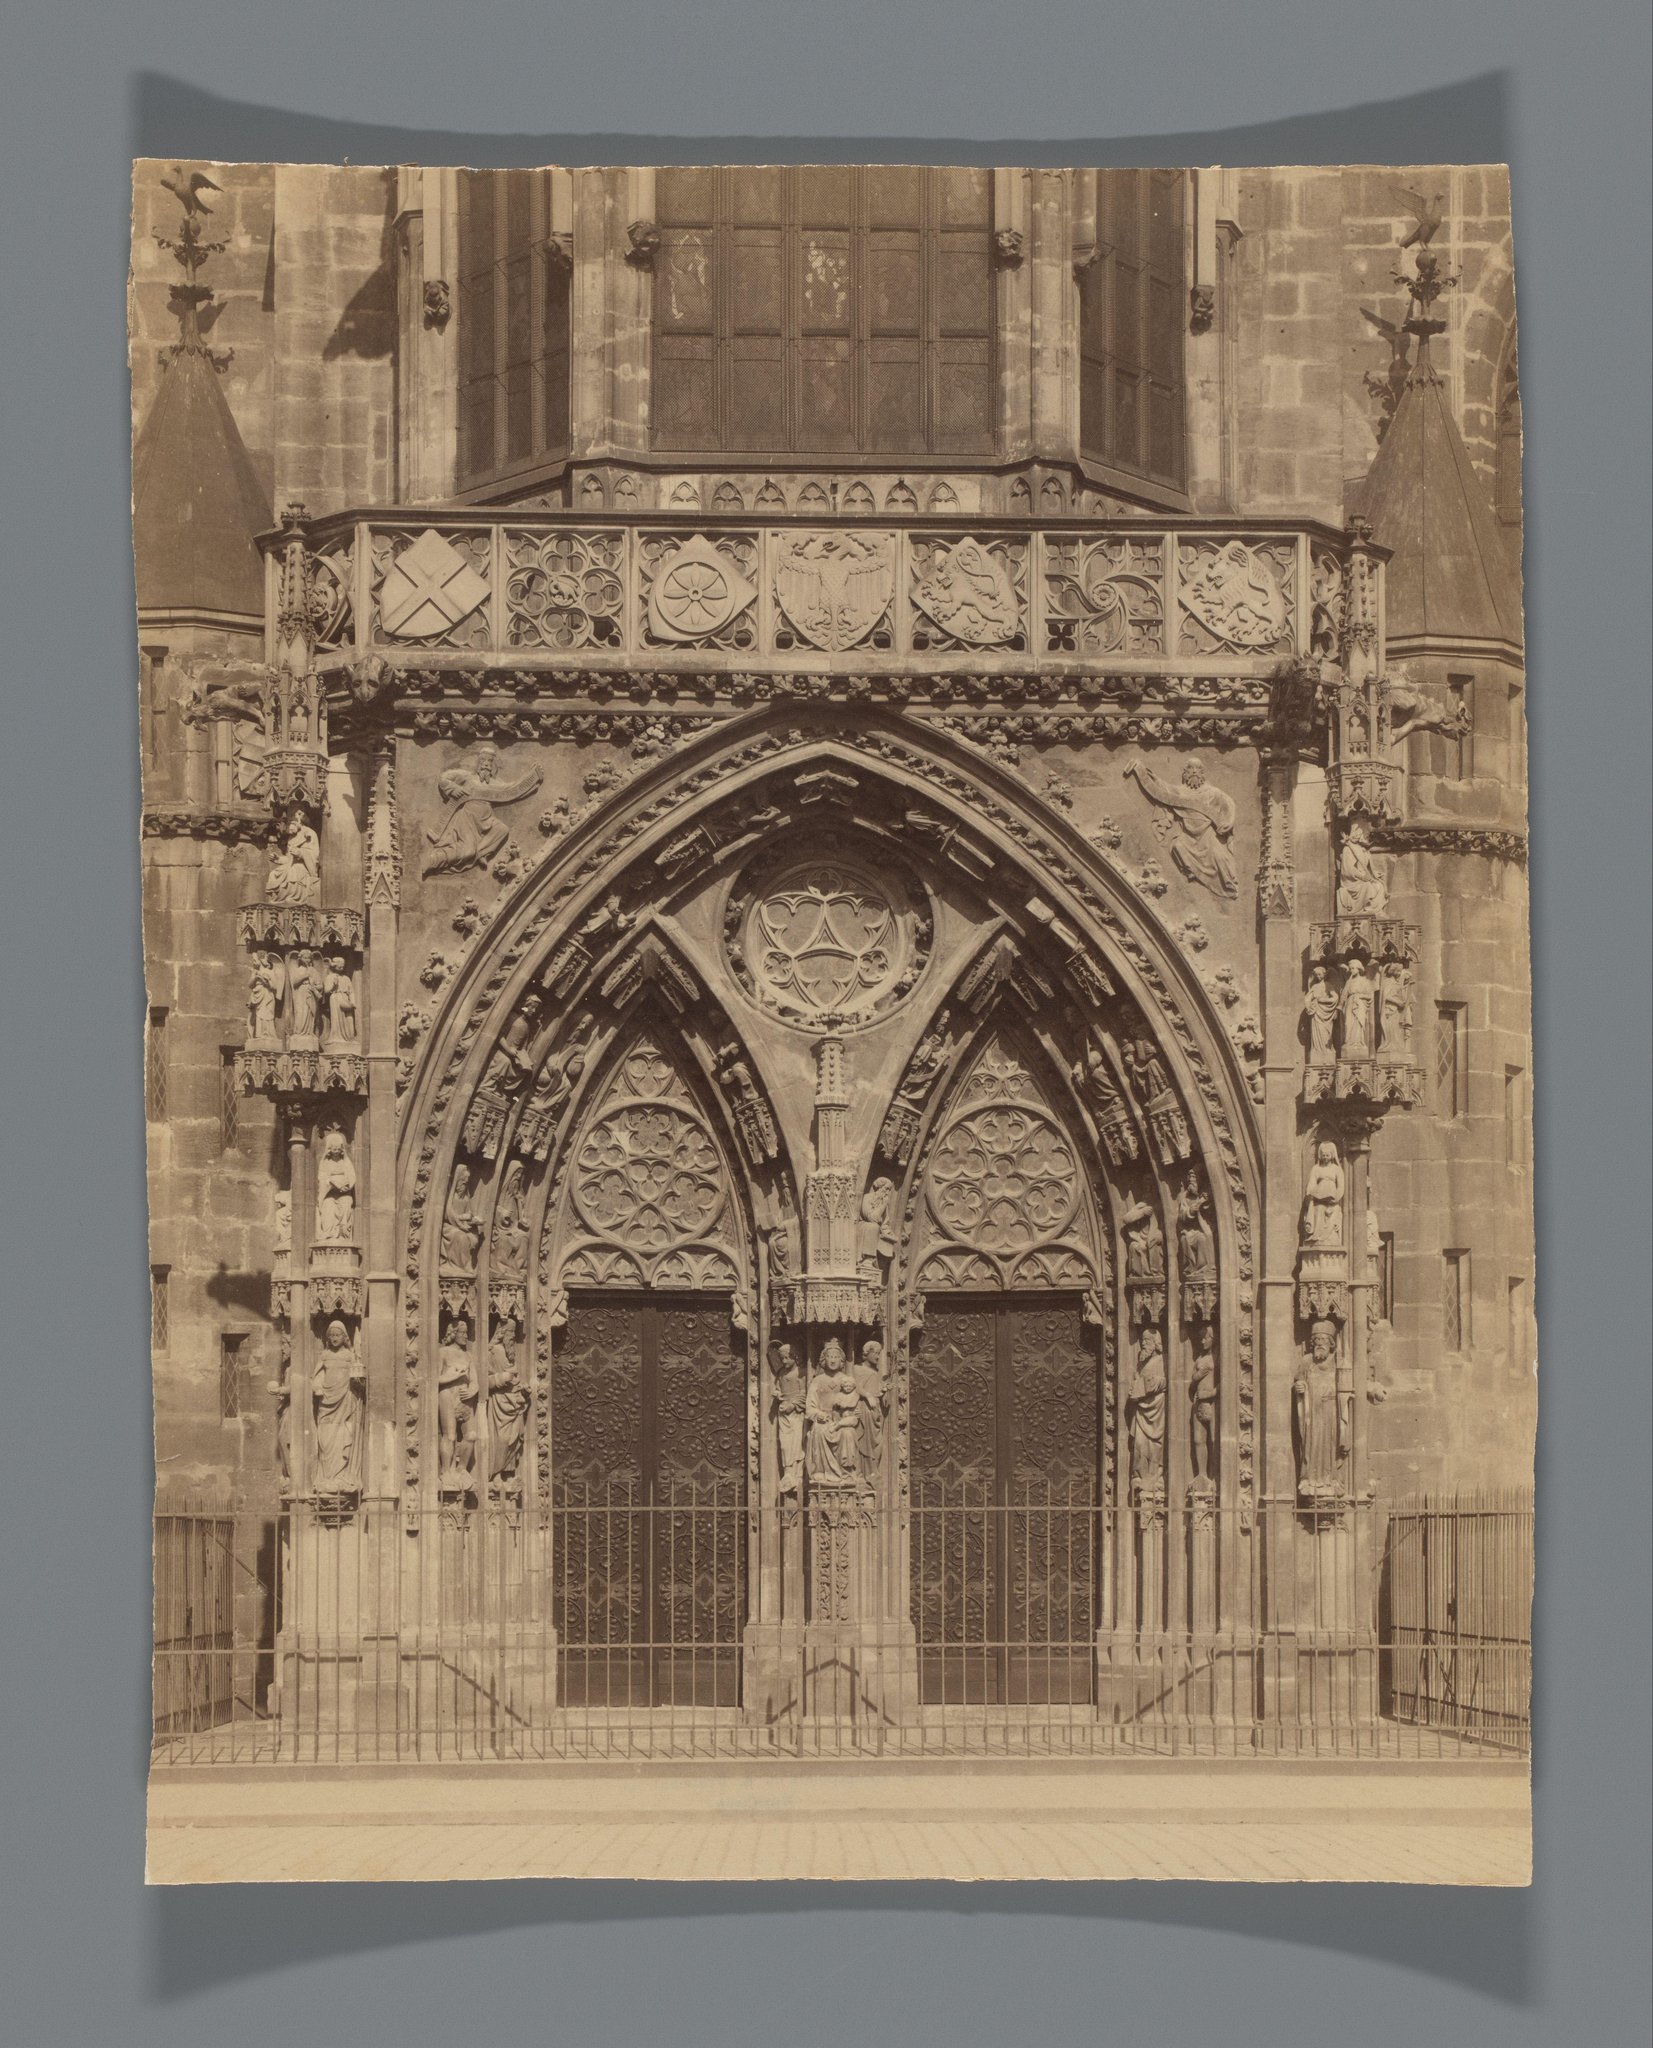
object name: photograph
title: Frauenkirche Nürnberg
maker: Anonymous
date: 1850-1900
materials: cardboard, photographic support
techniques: albumen print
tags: frauenkirche